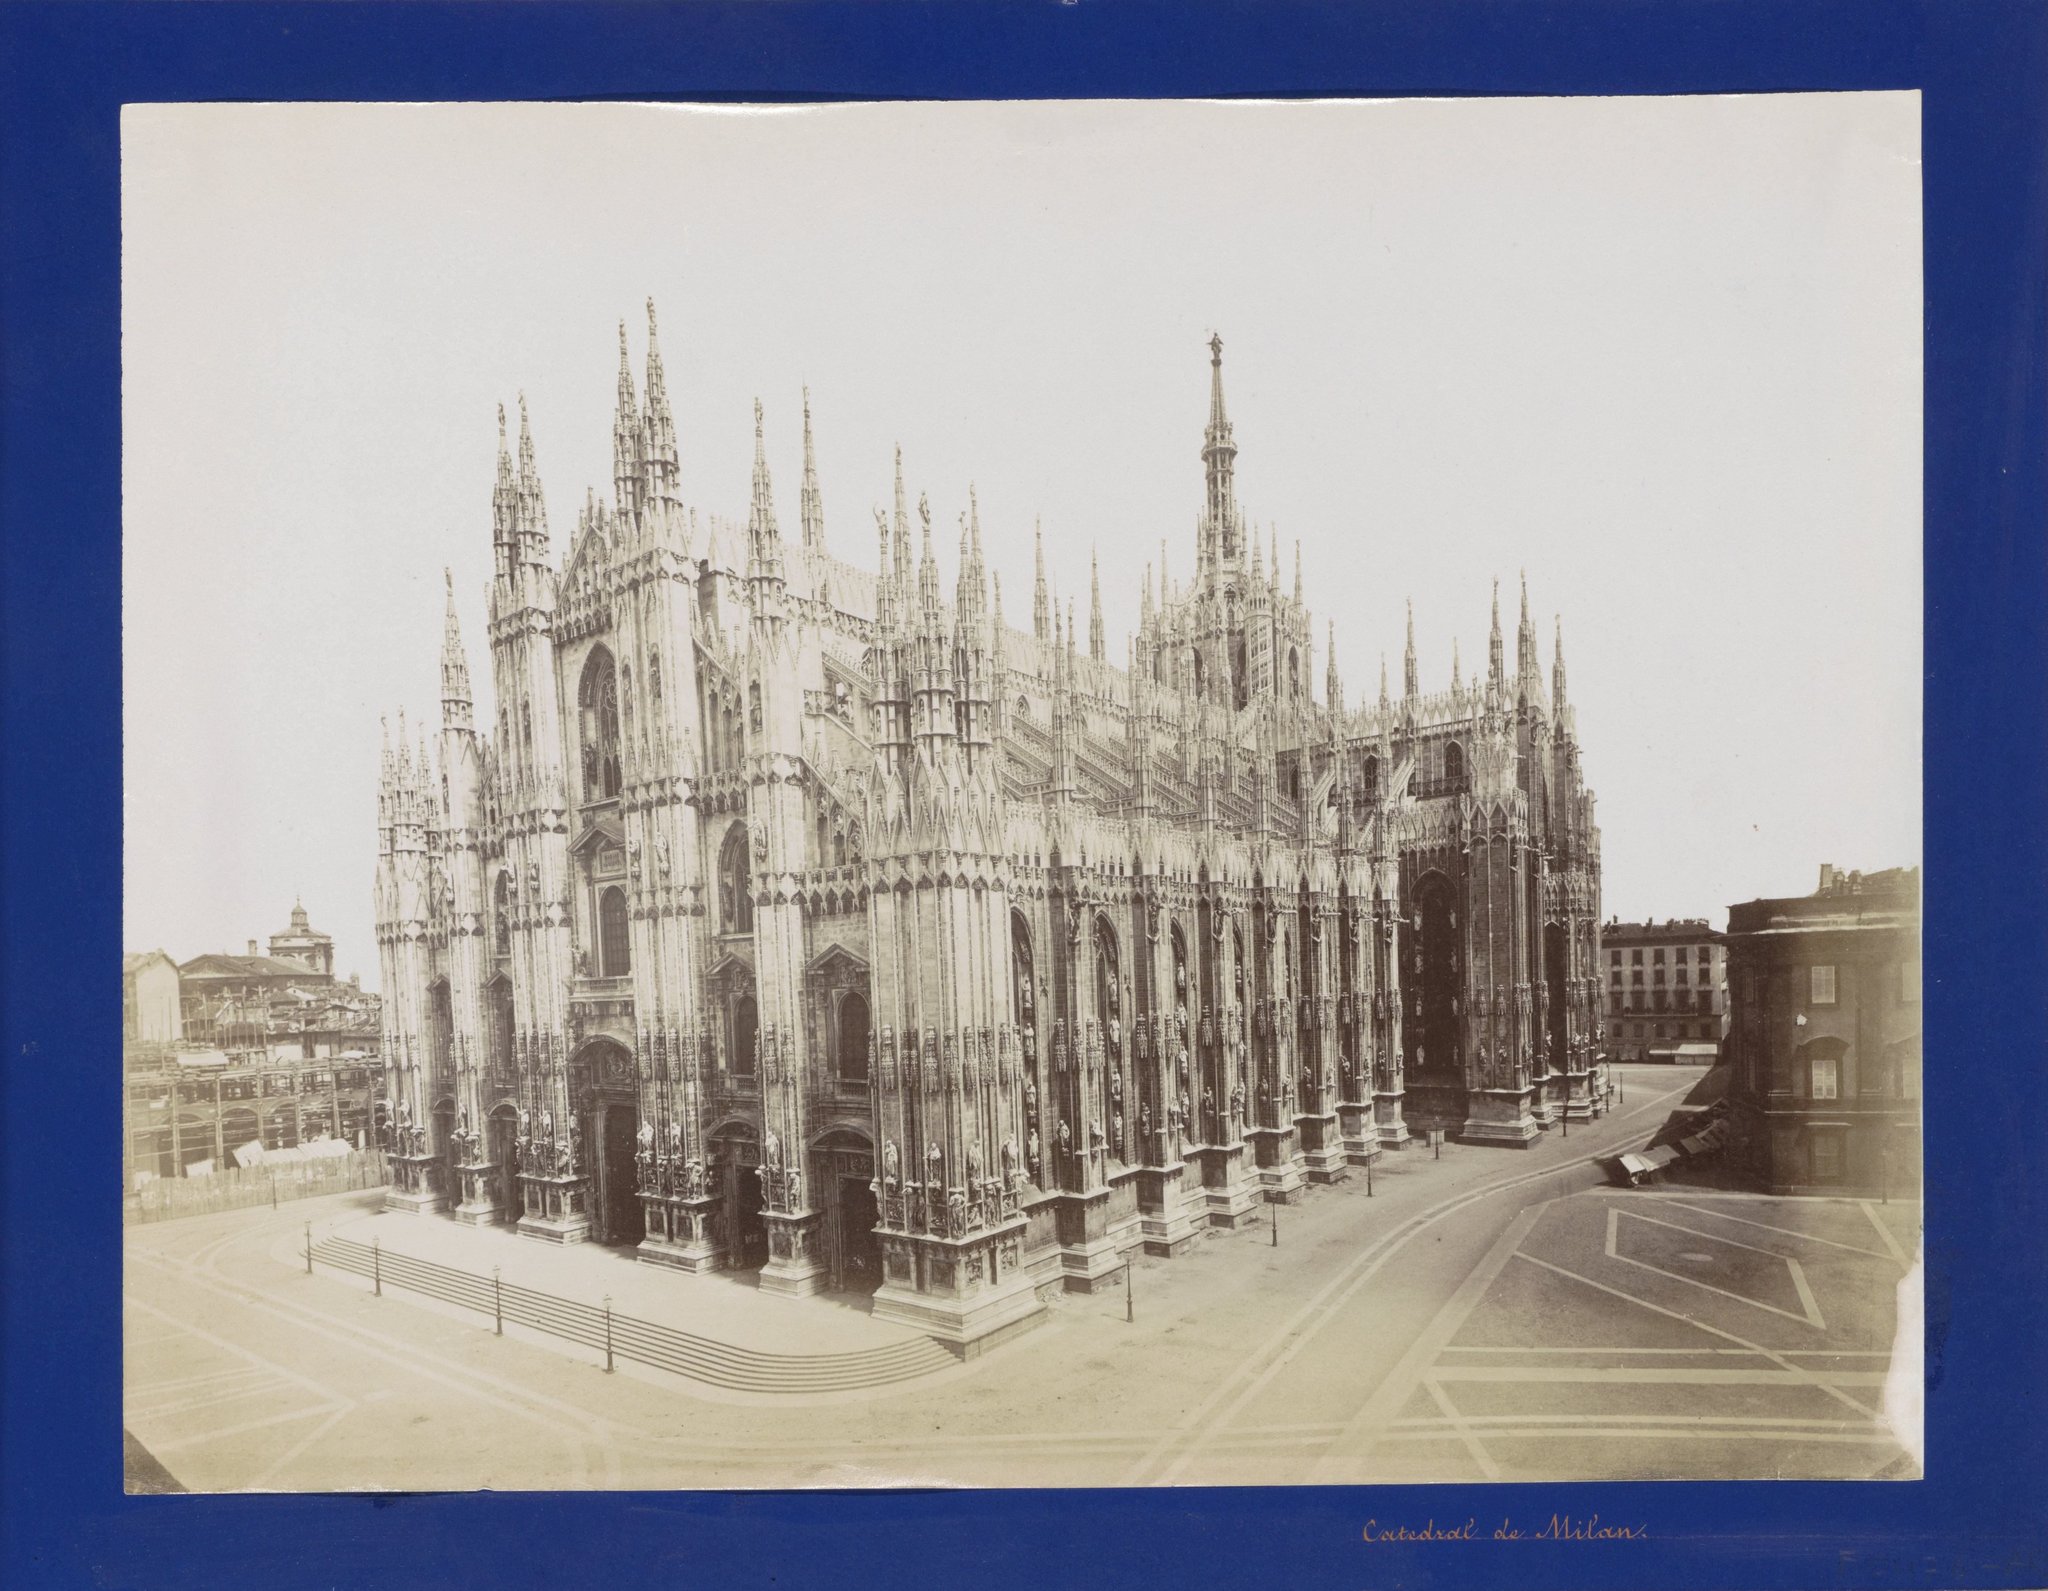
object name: photograph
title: Catedral de Milan.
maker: Anonymous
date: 1850-1876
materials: photographic support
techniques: albumen print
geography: milan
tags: church (exterior), travelling; tourism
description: Onderdeel van Reisalbum met foto's en tekeningen van Manuel Mayo 1876.